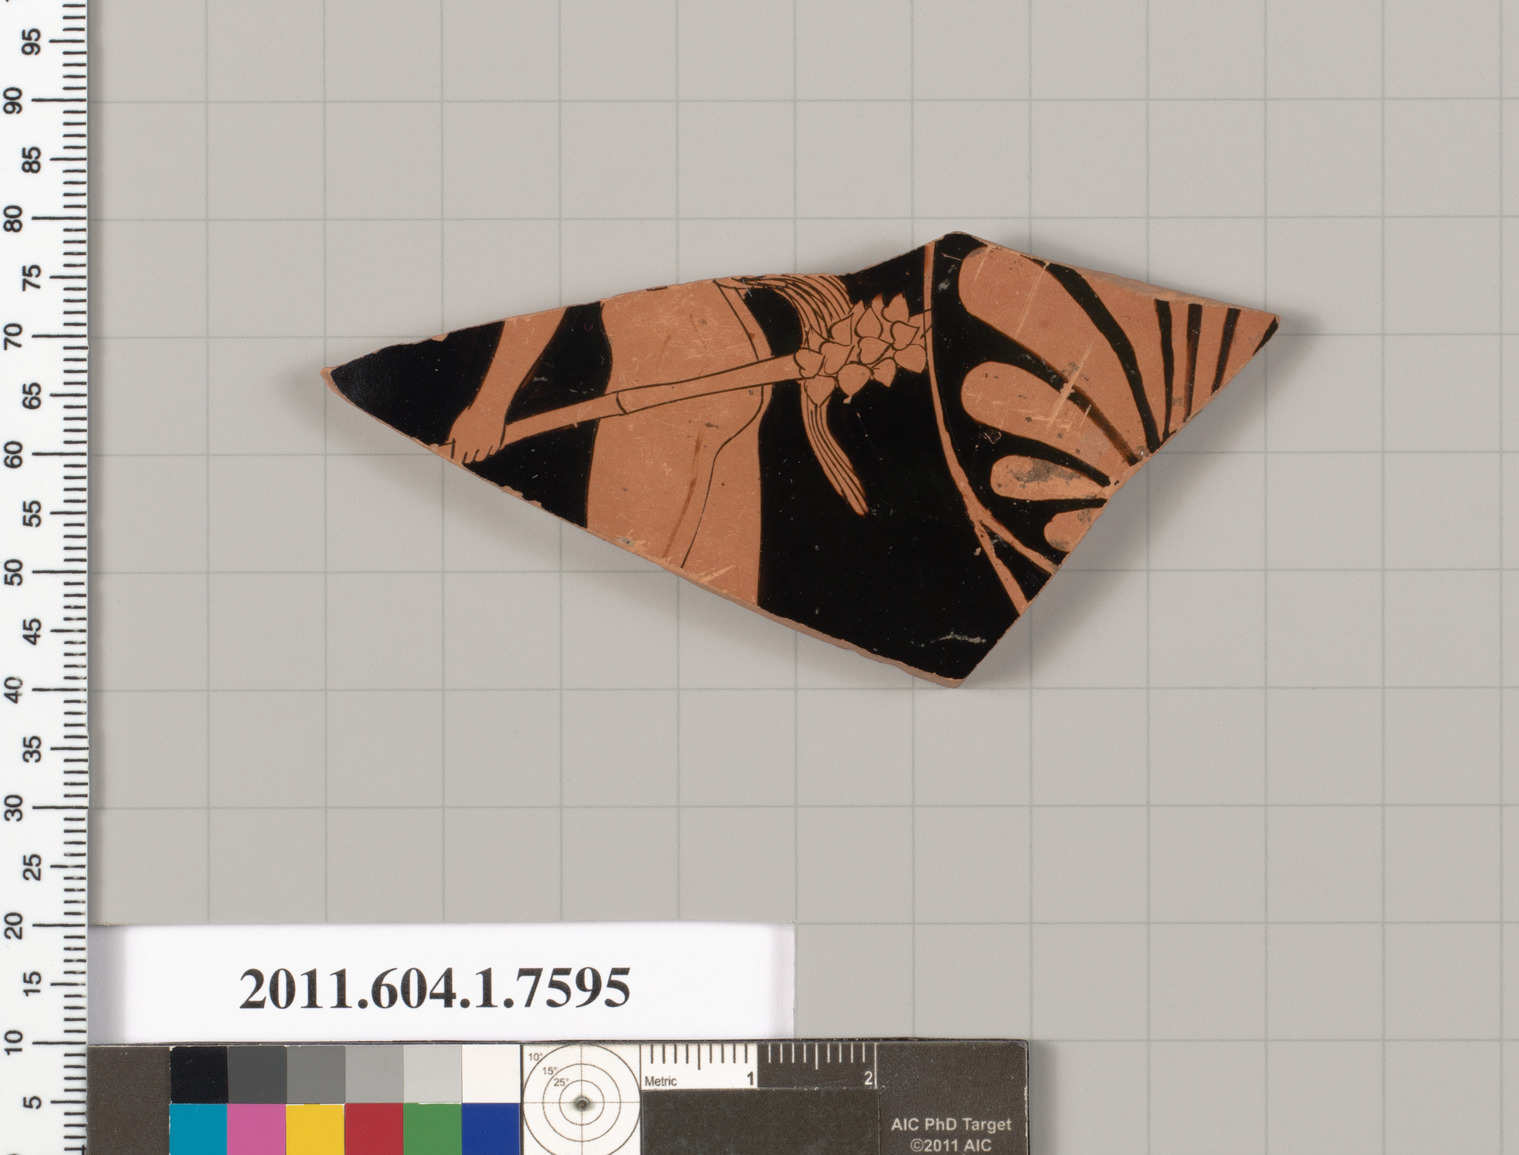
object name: kylix fragment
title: Terracotta fragment of a kylix (drinking cup)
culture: greek, attic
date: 460-450 BCE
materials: terracotta